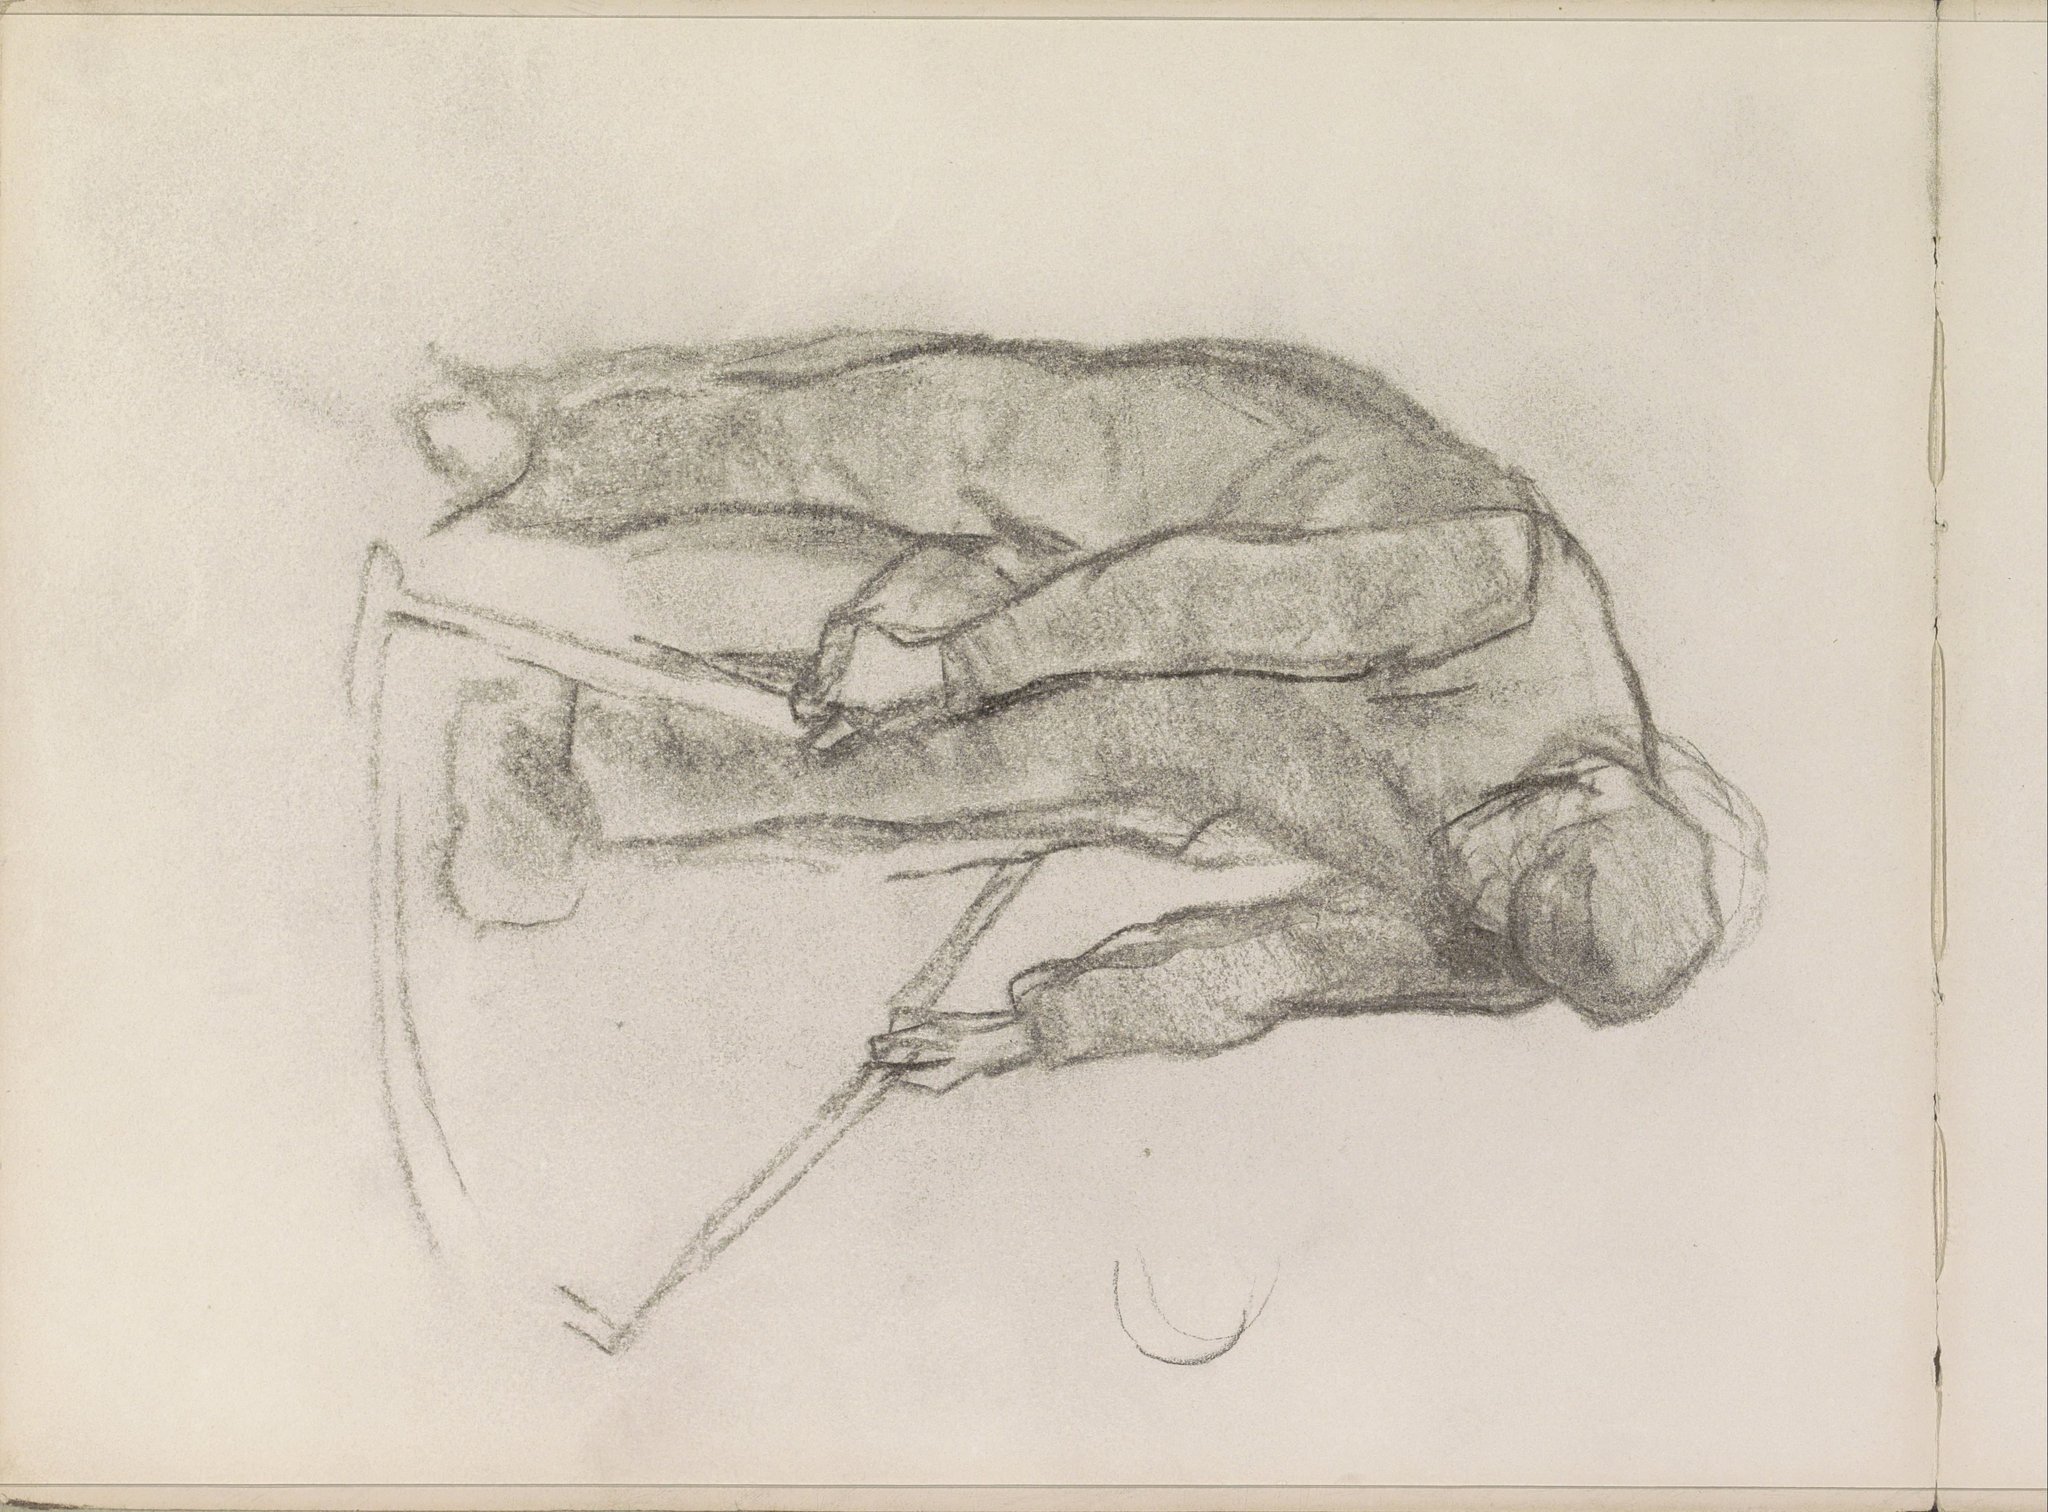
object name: sketchbook leaf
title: Boer met een zeis en pik om rogge te maaien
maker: anton mauve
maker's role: draughtsman, painter, print maker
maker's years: 1838-1888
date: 1886-1888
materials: chalk, paper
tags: agricultural implements: scythe, farmers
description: Blad 4 verso uit een schetsboek met 27 bladen.